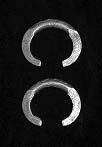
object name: bracelet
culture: thai, lu mien yao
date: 1900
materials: silver